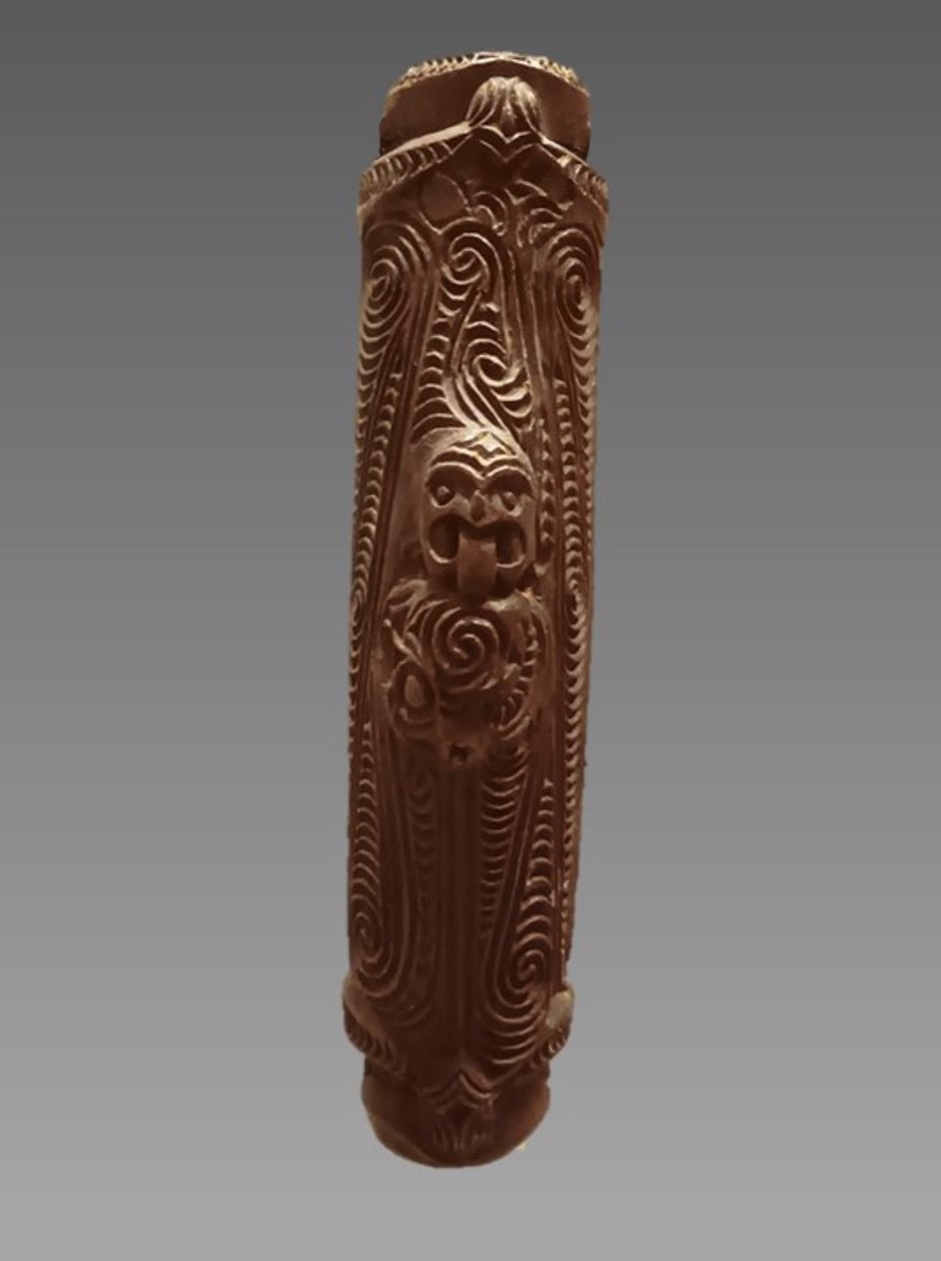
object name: kooauau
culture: maori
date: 1801-1833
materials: wood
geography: new zealand